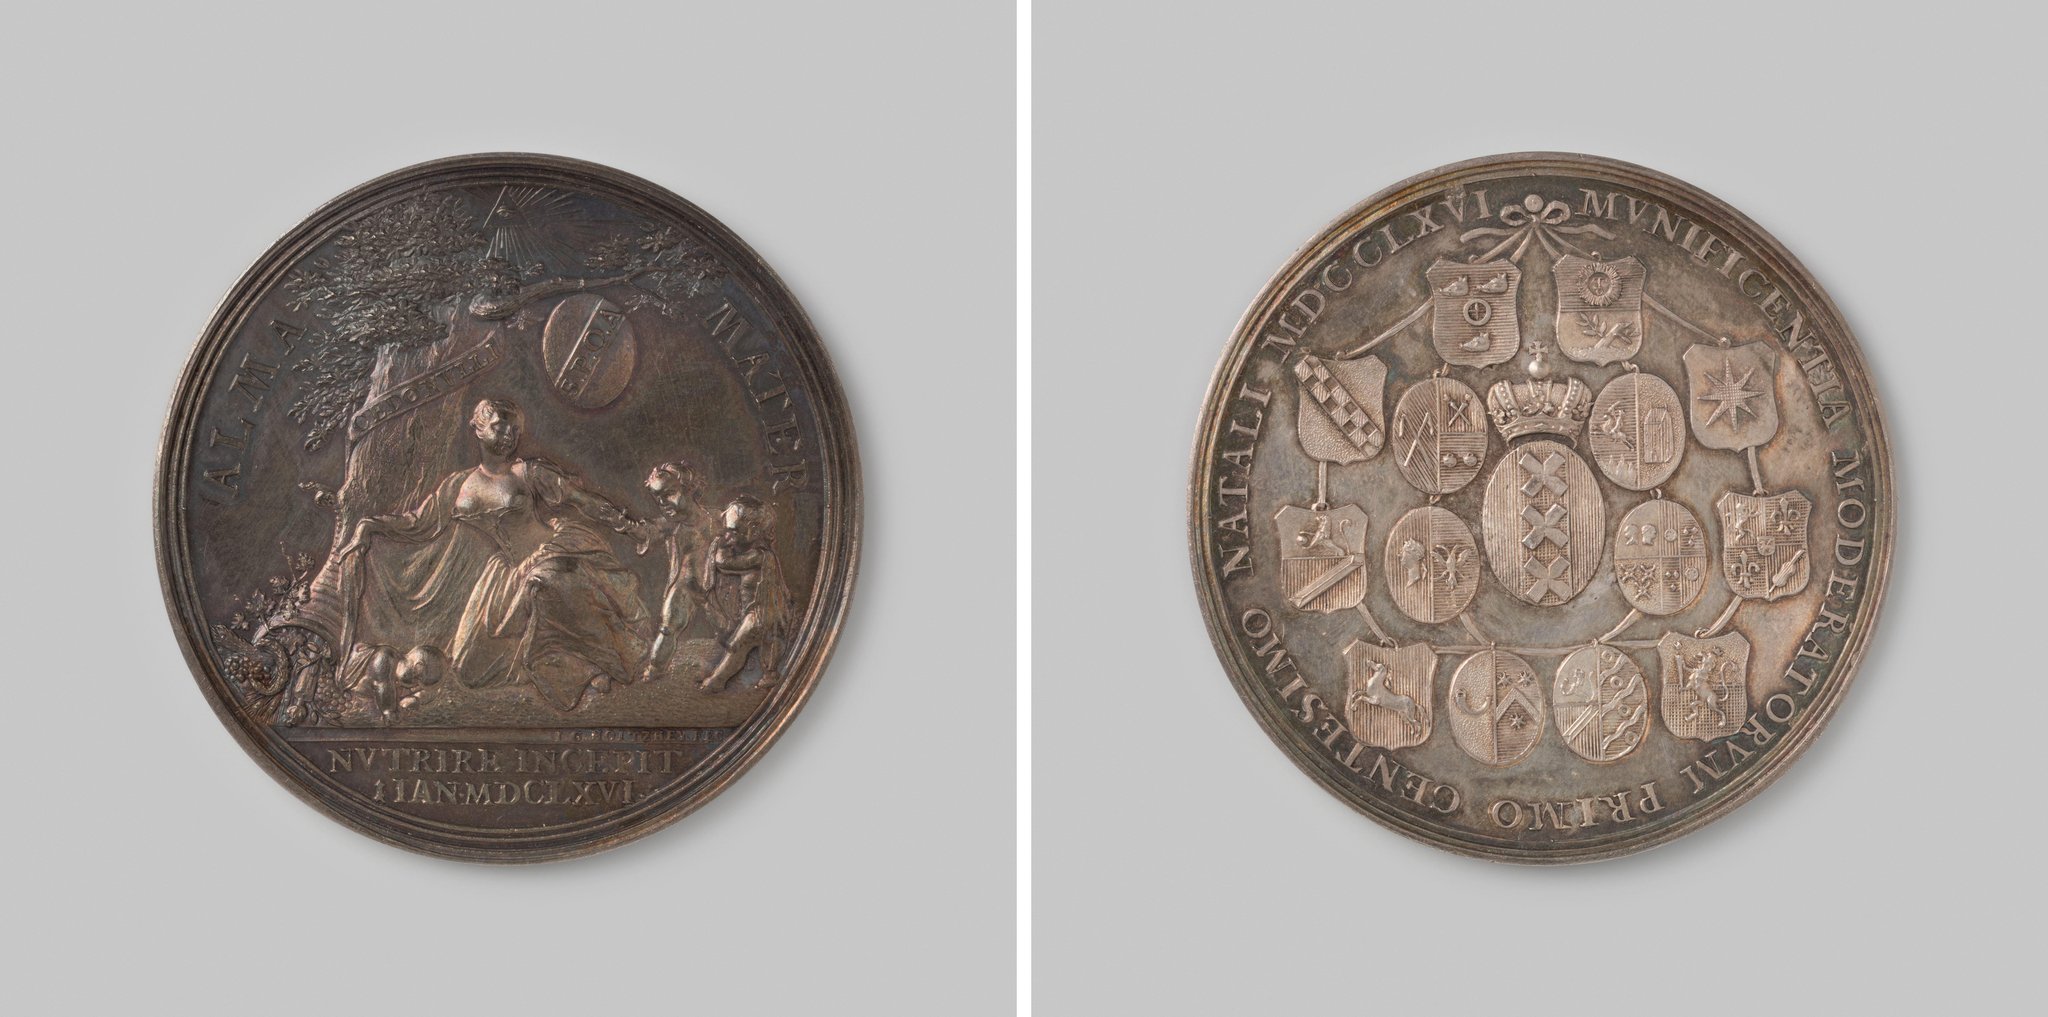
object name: history medal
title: Eerste eeuwfeest van het aalmoezeniersweeshuis te Amsterdam 1766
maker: johan george holtzhey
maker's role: mintmaster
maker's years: 1726-1808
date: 1766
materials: silver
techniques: striking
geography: amsterdam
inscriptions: circumscription: ‘MVNIFICENTIA MODERATORVM PRIMO CENTESIMO NATALI MDCCLXVI’, signature: ‘I. G. HOLTZHEY FEC’, : ‘NVTIRE INCEPIT I AN. MDCLXVI.’, circumscription: ‘ALMA MATER.’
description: Zilveren penning. Voorzijde: onder boom, waarin schild met opschrift hangt en waarvan stam is omwonden met lint met opschrift, zit vrouw, naast haar staat tegen de boom een omgekeerde hoorn van overvloed, waaruit graan, druiven, geld en een fakkel rollen, op voorgrond ligt kind op grond, dat door vrouw met sluier wordt bedekt, rechts twee huilende kinderen beschenen door alziend oog in stralende driehoek binnen omschrift, afsnede: opschrift. Keerzijde: gekroond wapenschild omgeven door veertien met lint samengebonden wapenschilden van regenten en regentessen van het weeshuis binnen omschrift